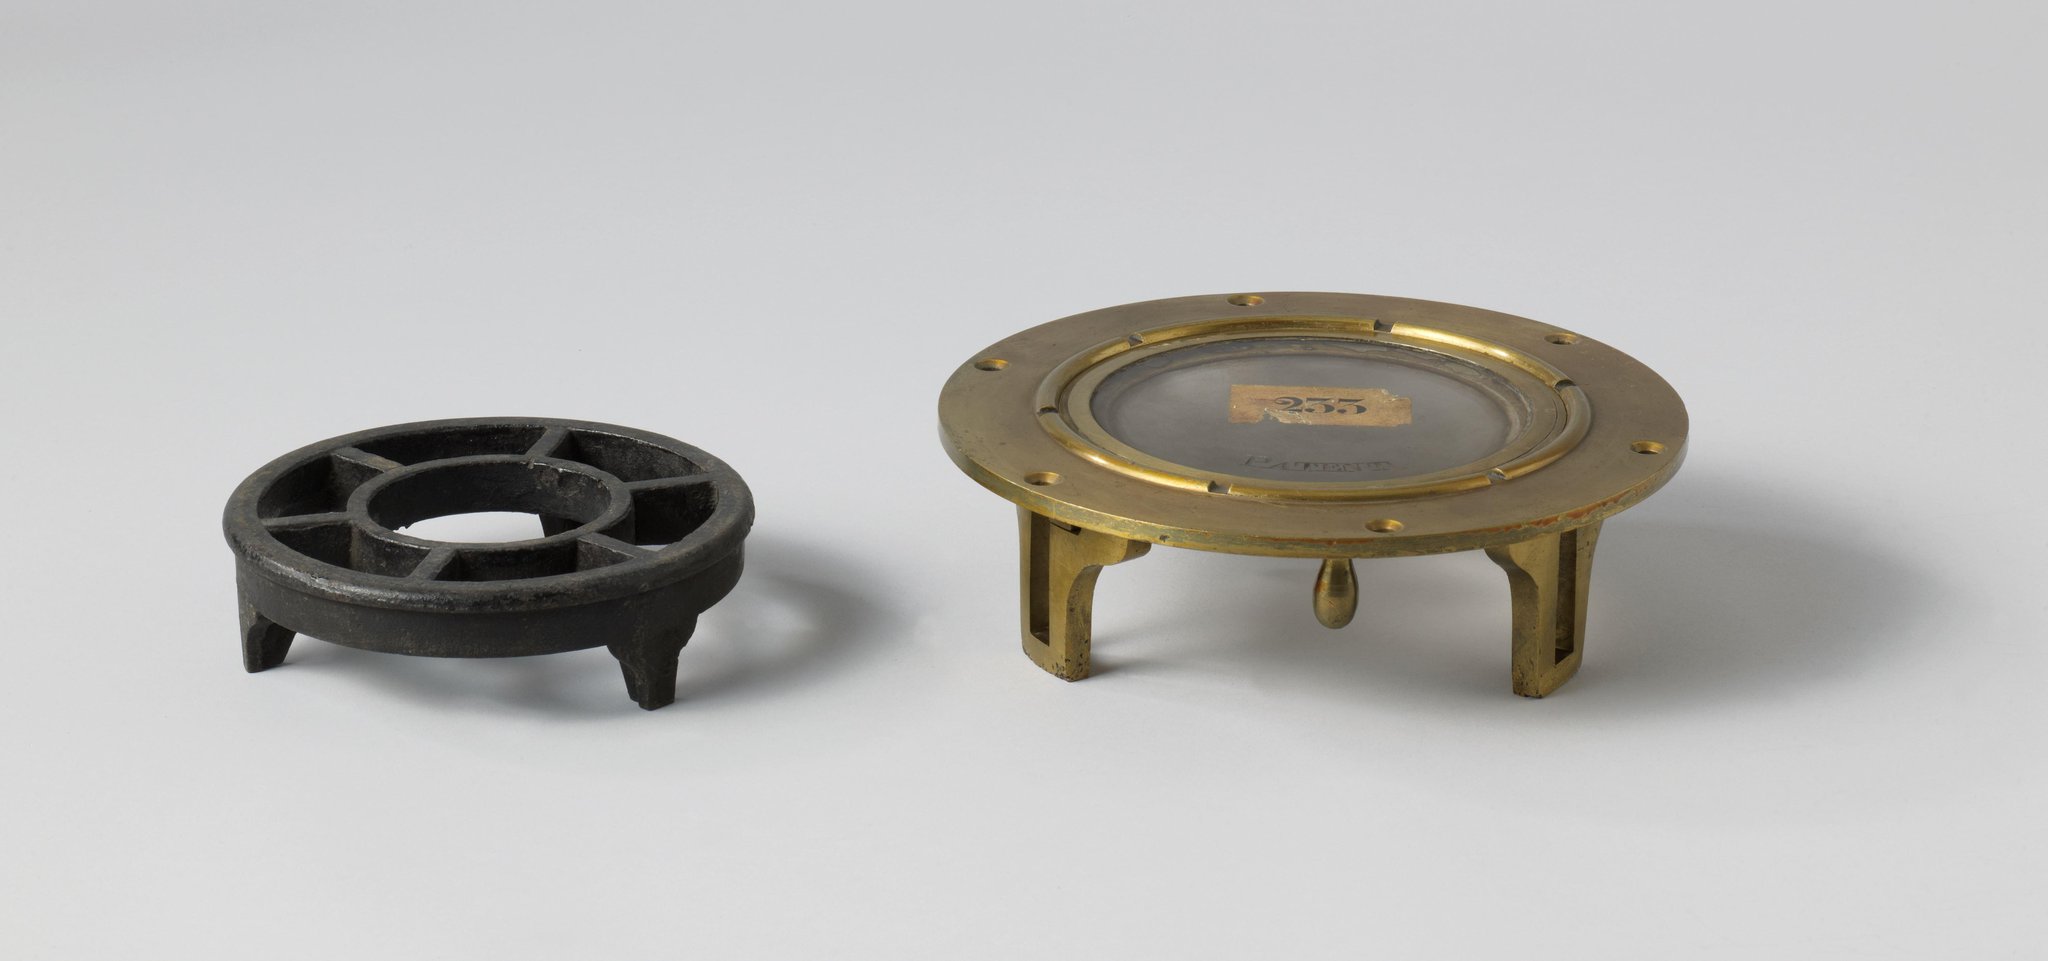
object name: portlight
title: Deck Light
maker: Anonymous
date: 1820-1830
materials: iron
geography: united kingdom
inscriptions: label: ‘233’, inscription: ‘PATENT’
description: Gietijzeren rooster horend bij een patentglas.